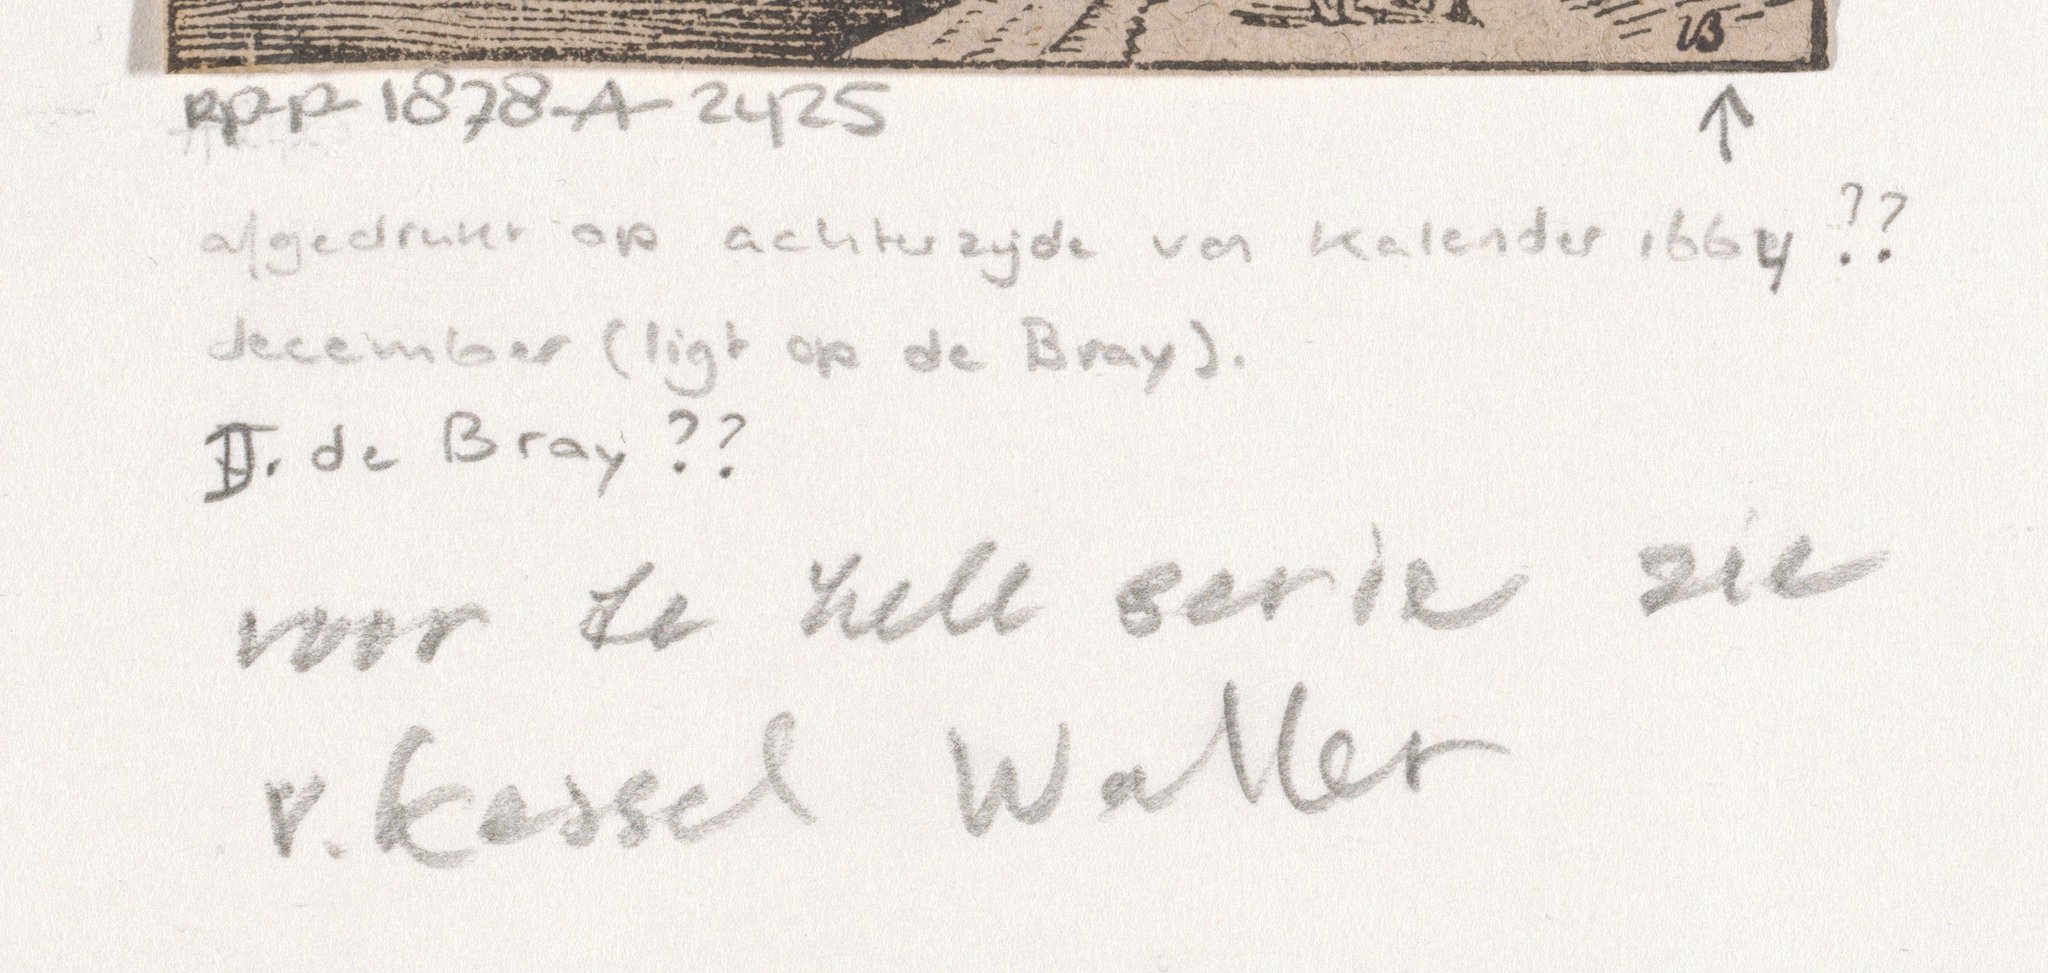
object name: print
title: Landschap met een huis op palen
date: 1628-1659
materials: paper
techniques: woodcut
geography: netherlands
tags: lake-dwelling, pile-dwelling, farm or solitary house in landscape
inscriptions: collector's mark: Lugt 2228